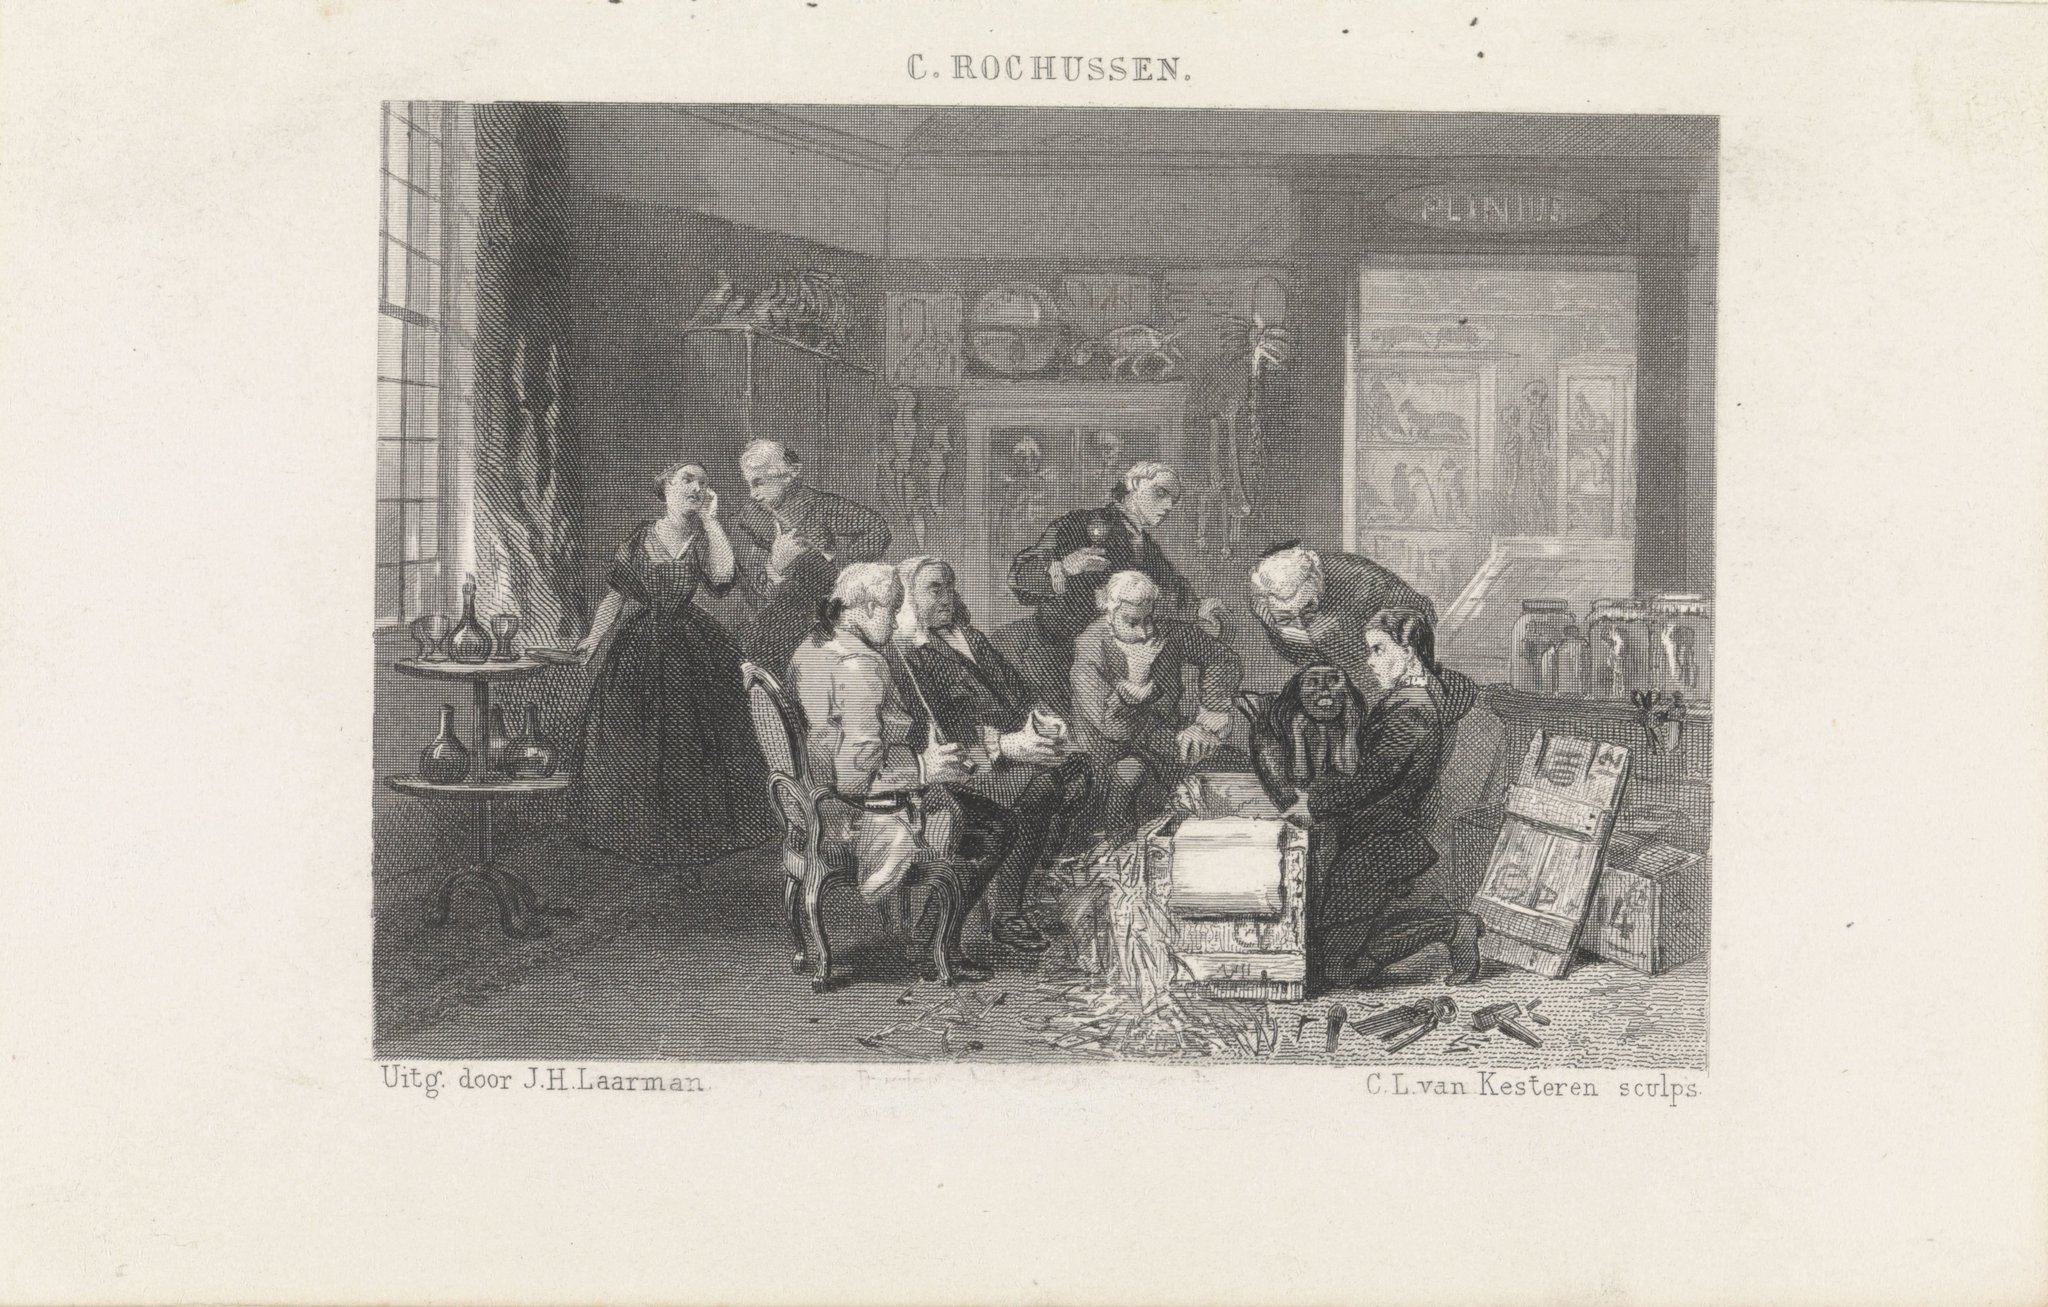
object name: print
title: Rariteitenkabinet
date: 1868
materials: paper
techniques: engraving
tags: merman - aa - mermaid, siren, cabinet of curiosities, 'kunst- und wunderkammer'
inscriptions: collector's mark: Lugt 2228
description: In het vertrek staan potten met organismen op sterk water. Links een man en een vrouw in gesprek. Boven de deuropening staat ‘Plinius’.